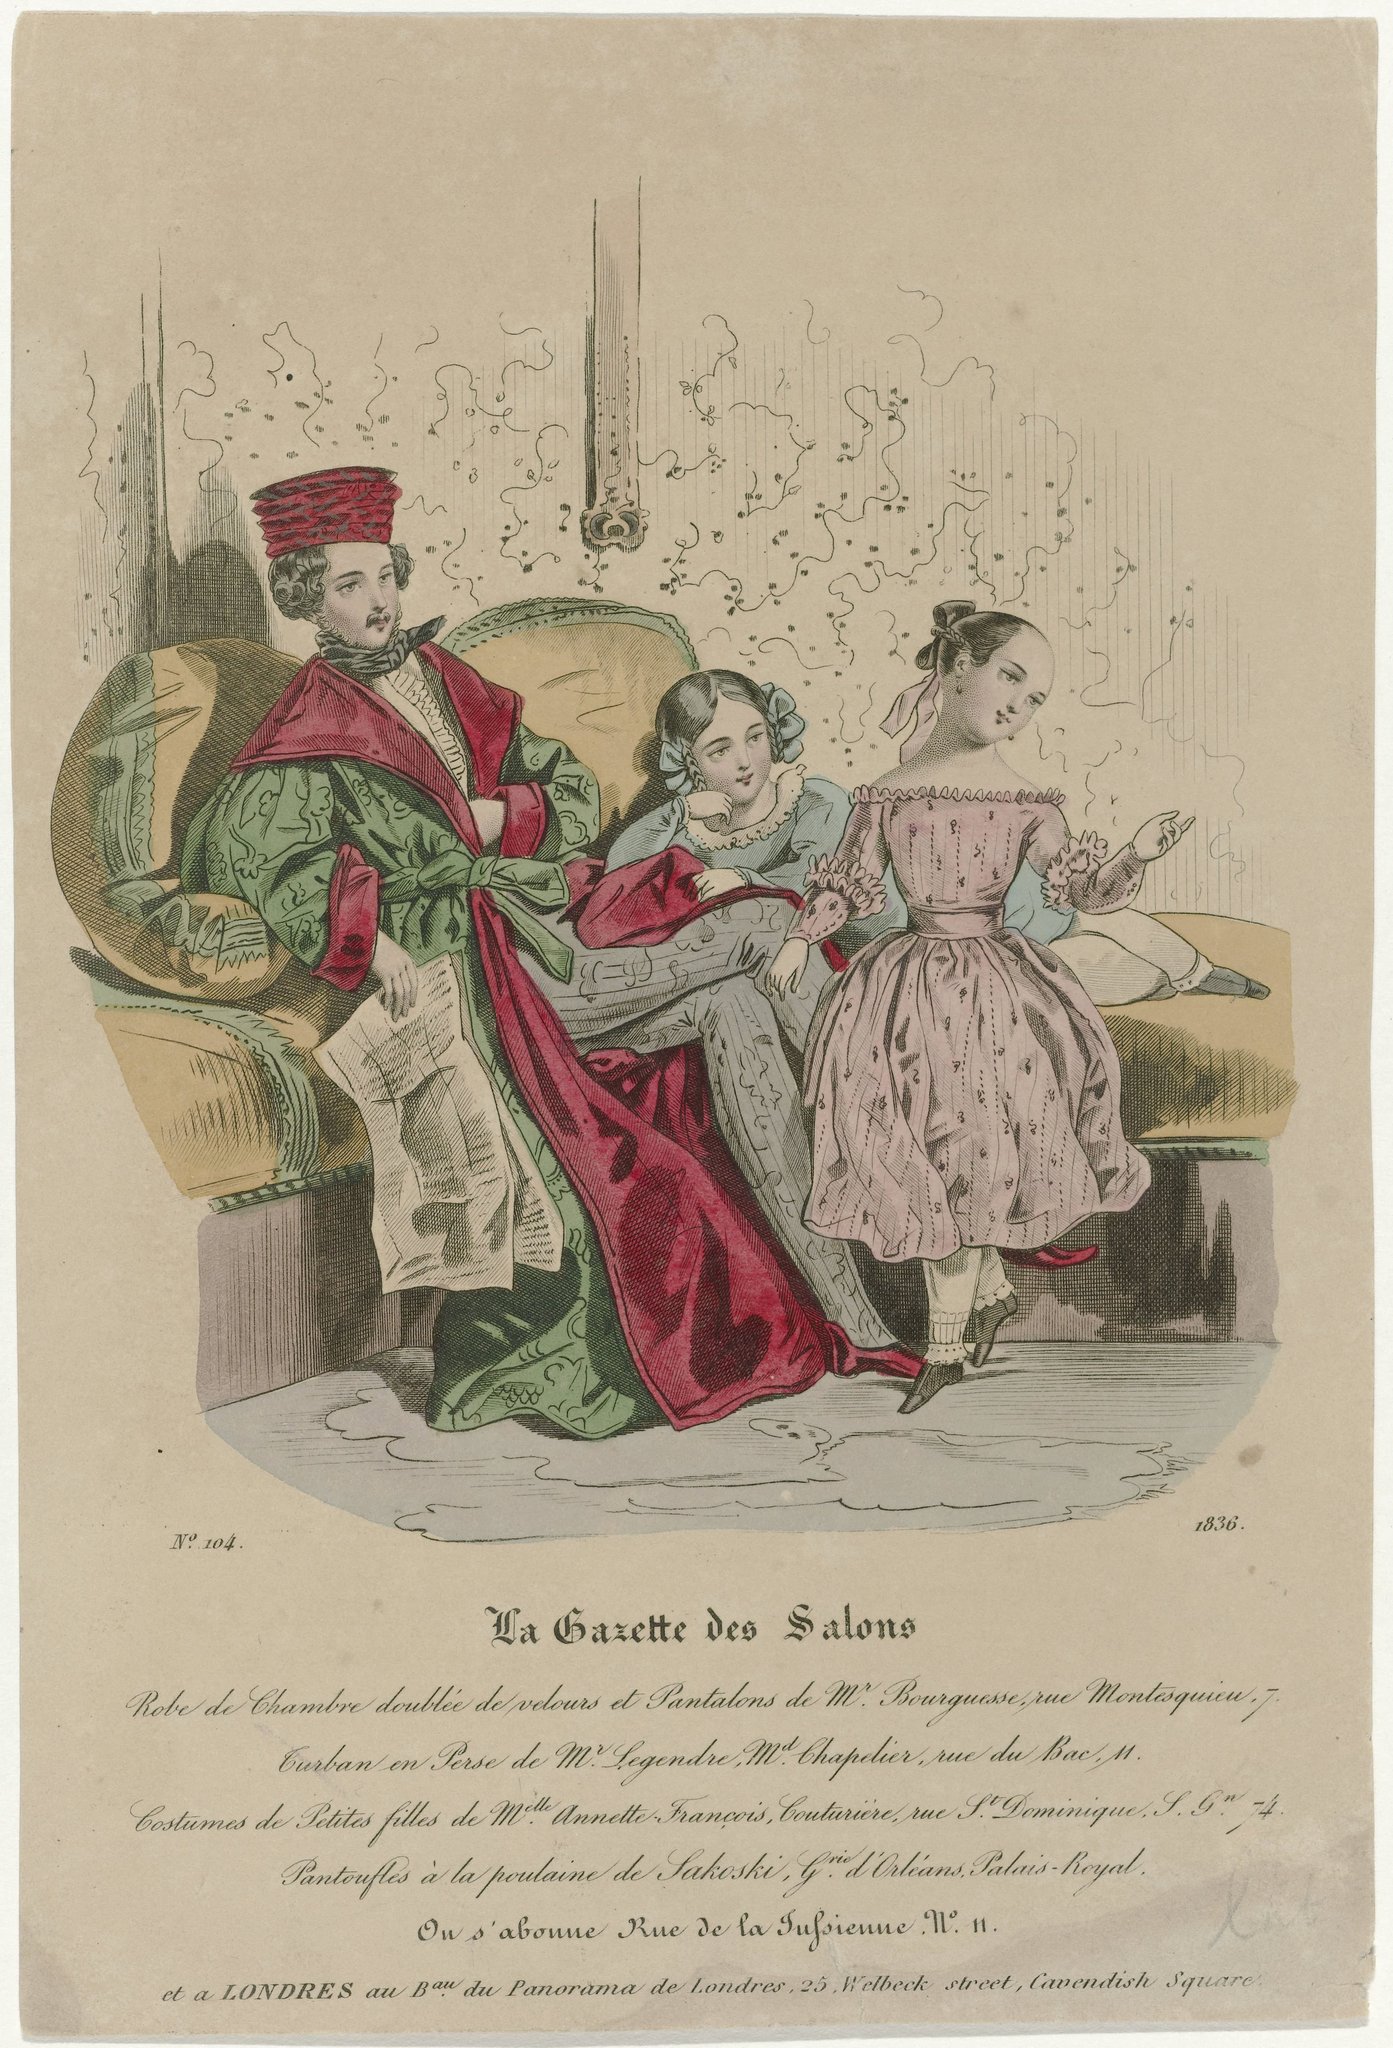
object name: fashion print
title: La Gazette des Salons, 1836, No. 104: Robe de Chambr (...)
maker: Anonymous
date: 1836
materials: paper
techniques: engraving, hand coloring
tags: clothes, costume (+ girls' clothes), neck-gear ~ clothing (+ men's clothes), nightwear (+ men's clothes), head-gear: turban (+ men's clothes), trousers, breeches (+ men's clothes), housecoat (+ men's clothes), fashion plates, shoes, sandals (+ men's clothes), newspaper, news-sheet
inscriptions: title: ‘La Gazette des Salons.’, address: ‘On s'abonne Rue de la Jussienne, No. 11. / et à Londres au B.au du Panorama de Londres, 25, Welbeck Street, Cavendish Square.’, caption: ‘Robe de Chambre doublée de velours et Pantalons de M.r Bourguesse, rue Montesquieu, 7. Turban en Perse de M.r Legendre, M.d Chapelier, rue du Bac, 11. Costumes de Petites filles de M.elle Annette François, Couturière, rue S.t Dominique, S. G.n 74. Pantoufles à la poulaine de Sakoski, G.rie d'Orléans. Palais-Royal.’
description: Kamerjas gevoerd met fluweel en lange broeken van Mr Bourguesse. 'Turban en Perse' van Mr Legendre. Kostuums van de kleine meisjes van Annette-François, Couturière. Pantoffels met puntige neuzen van Sakoski. Prent uit het modetijdschrift La Gazette des Salons (1835-1837).